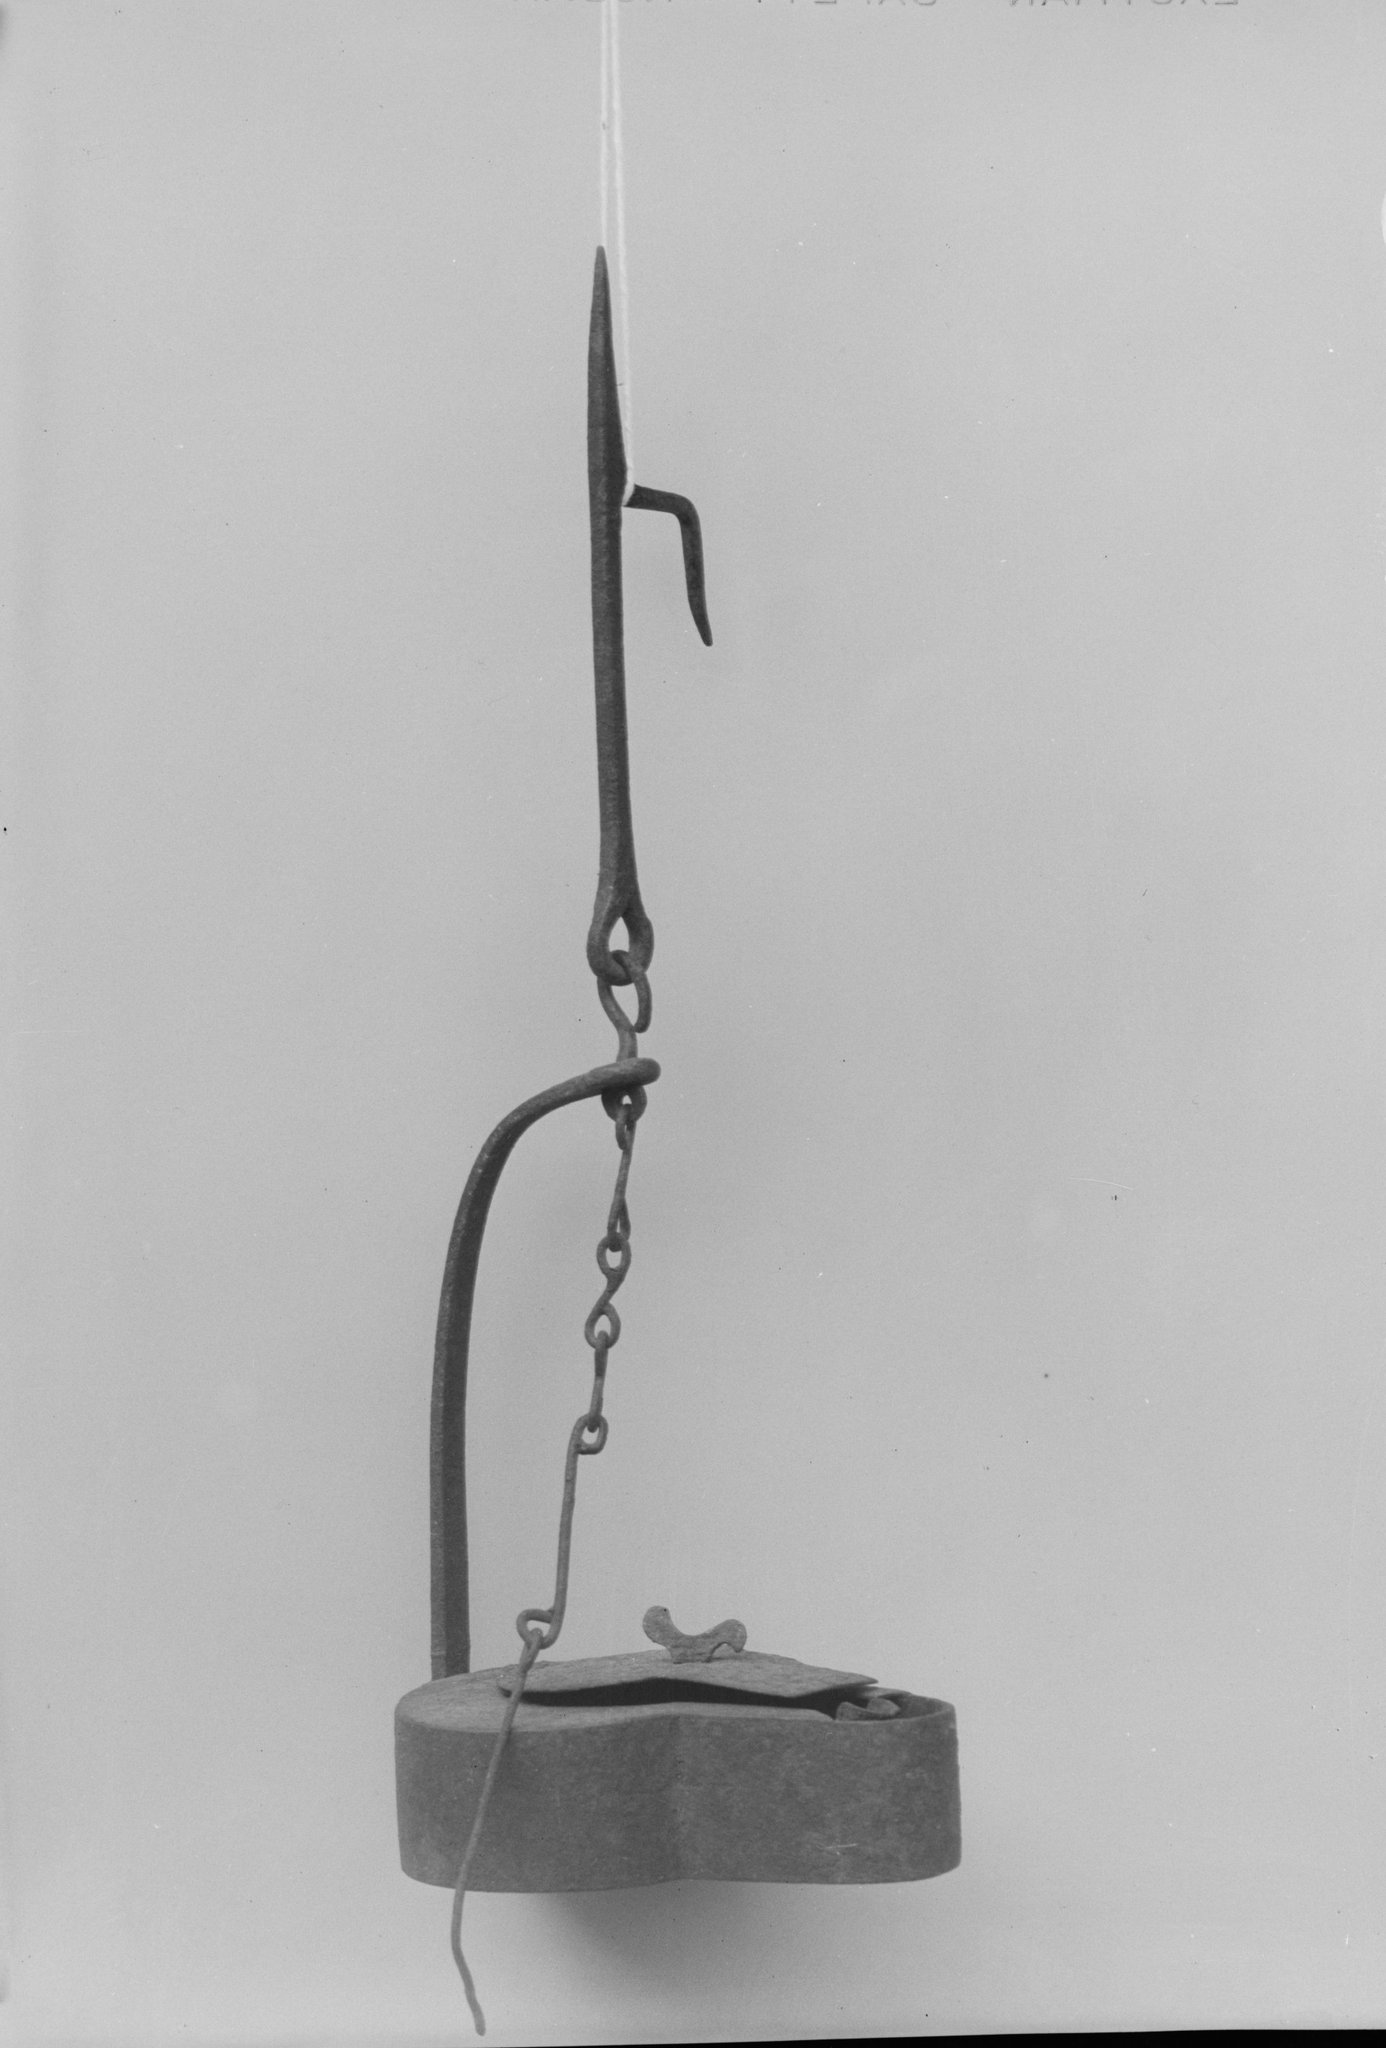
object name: betty lamp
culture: american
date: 1725-1775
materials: iron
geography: united states